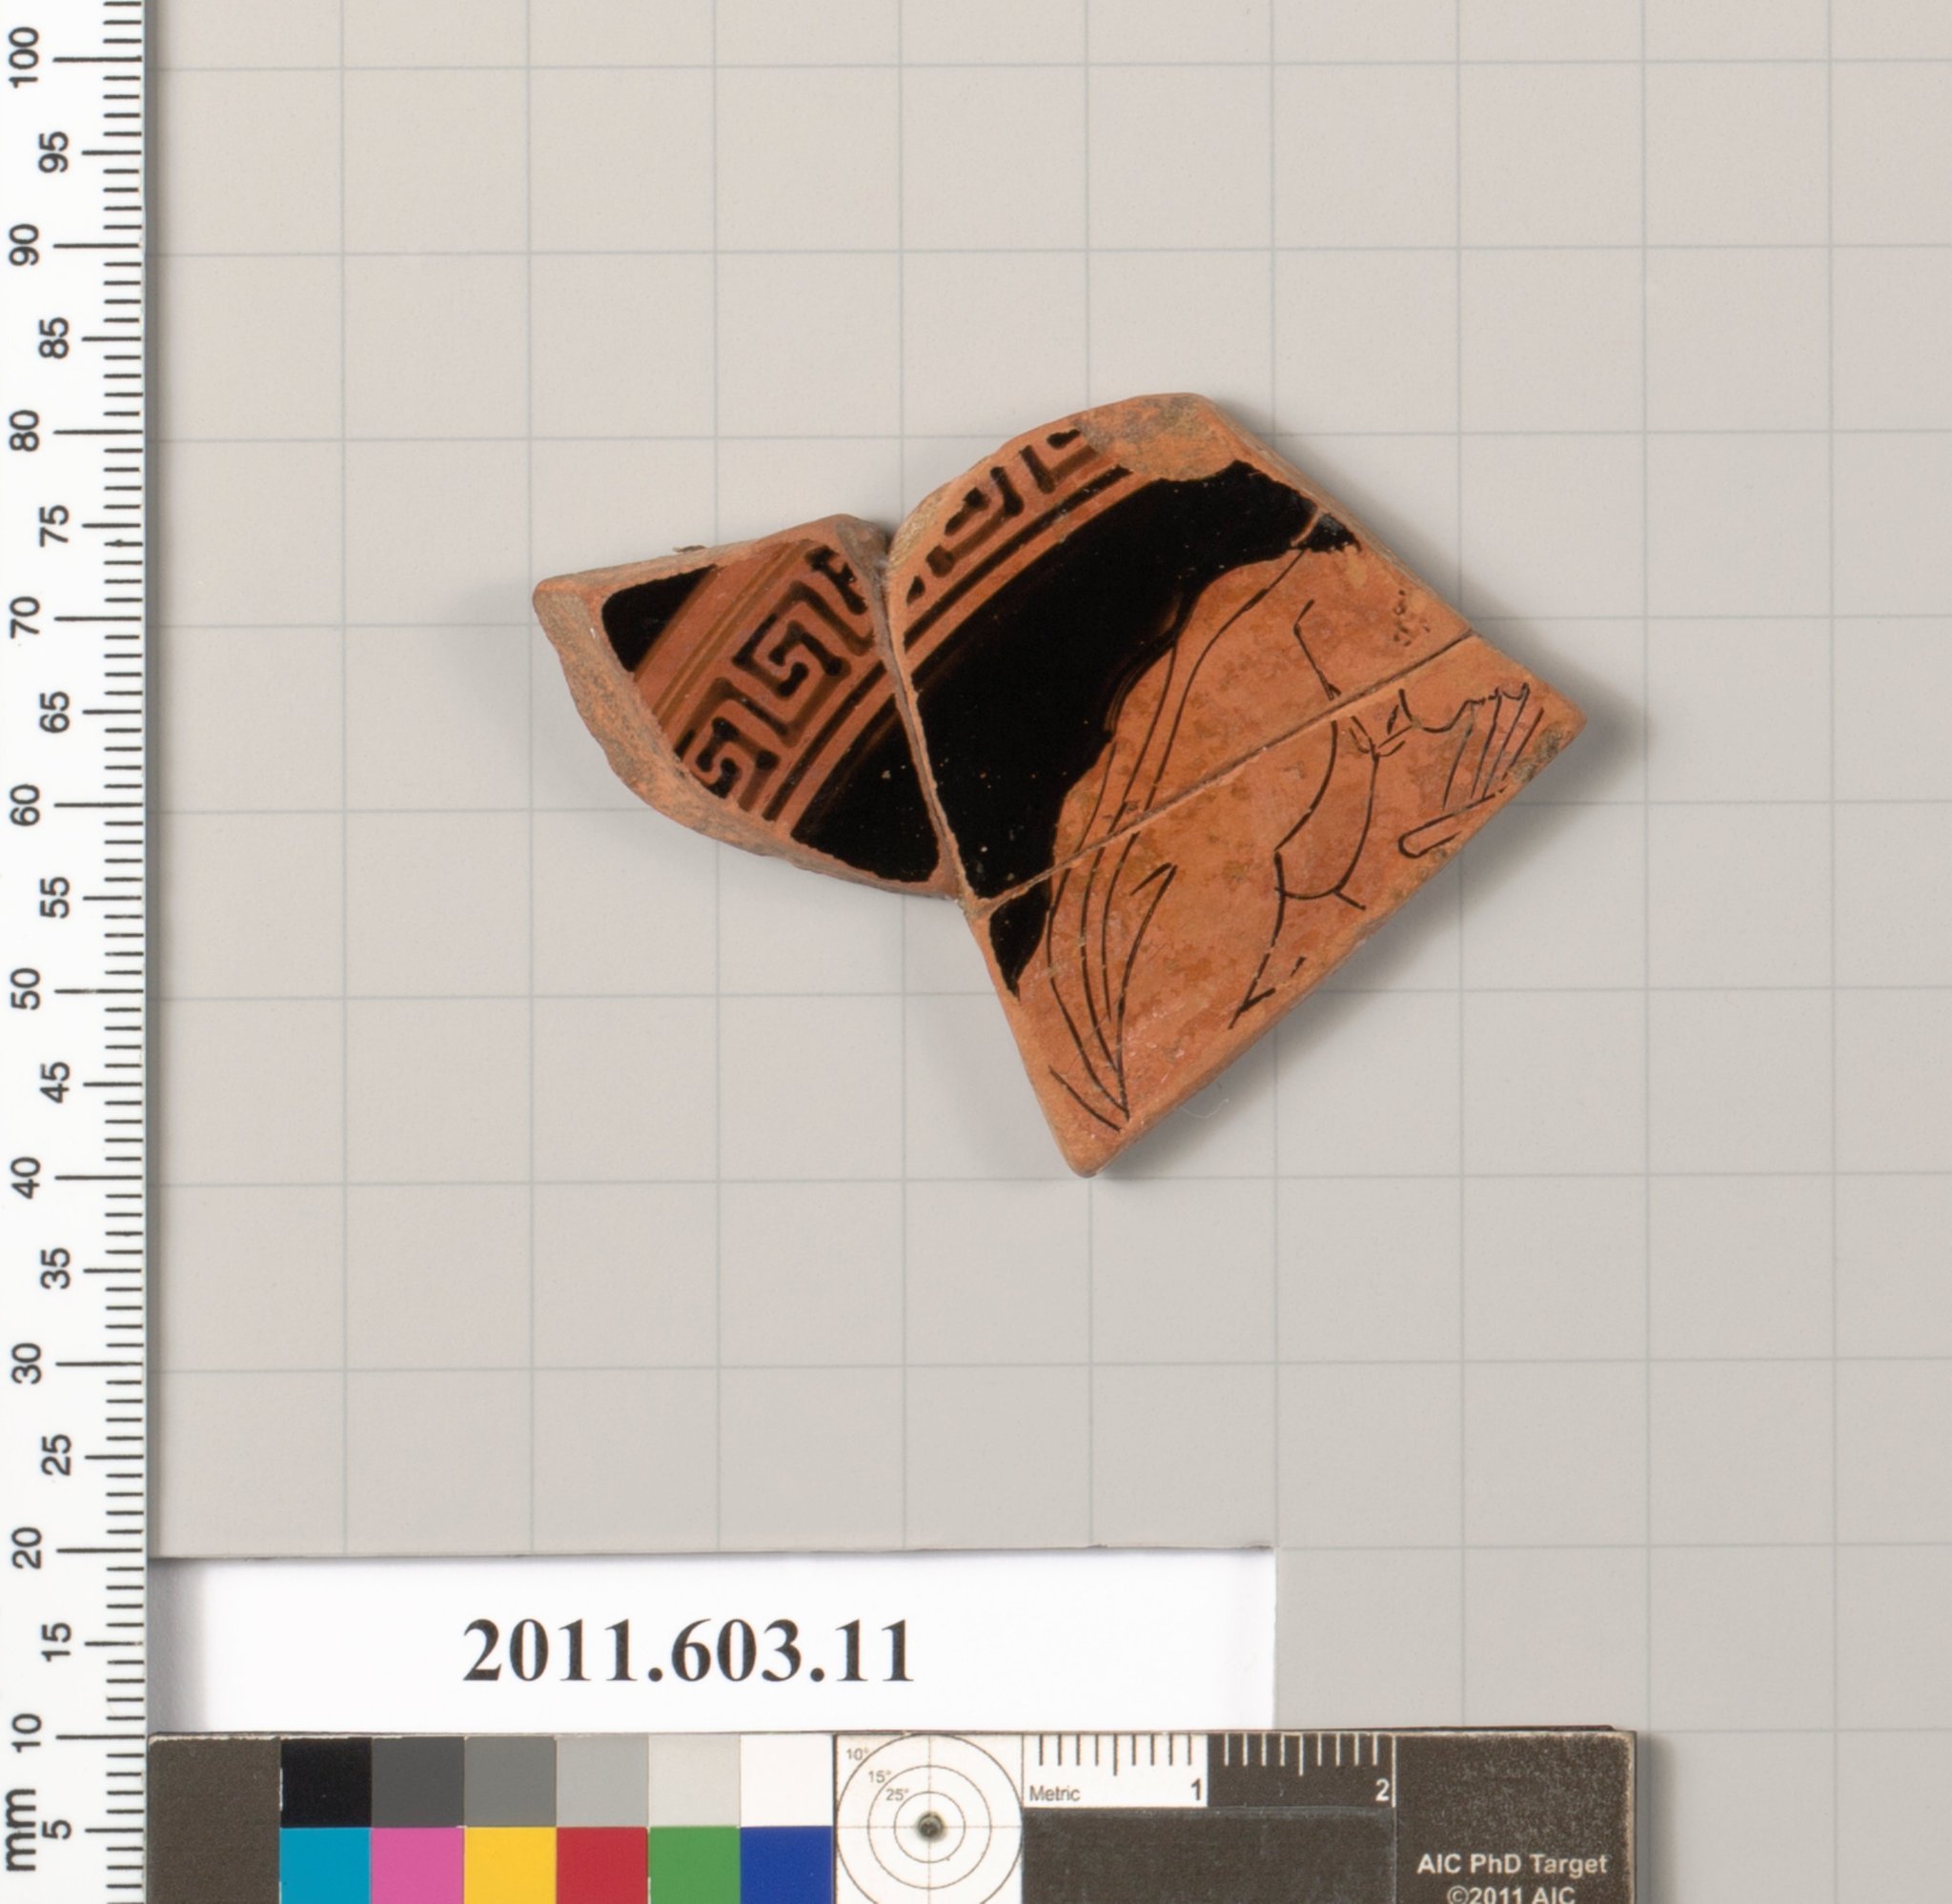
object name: kylix fragment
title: Fragment of a terracotta kylix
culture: greek, attic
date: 480 BCE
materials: terracotta